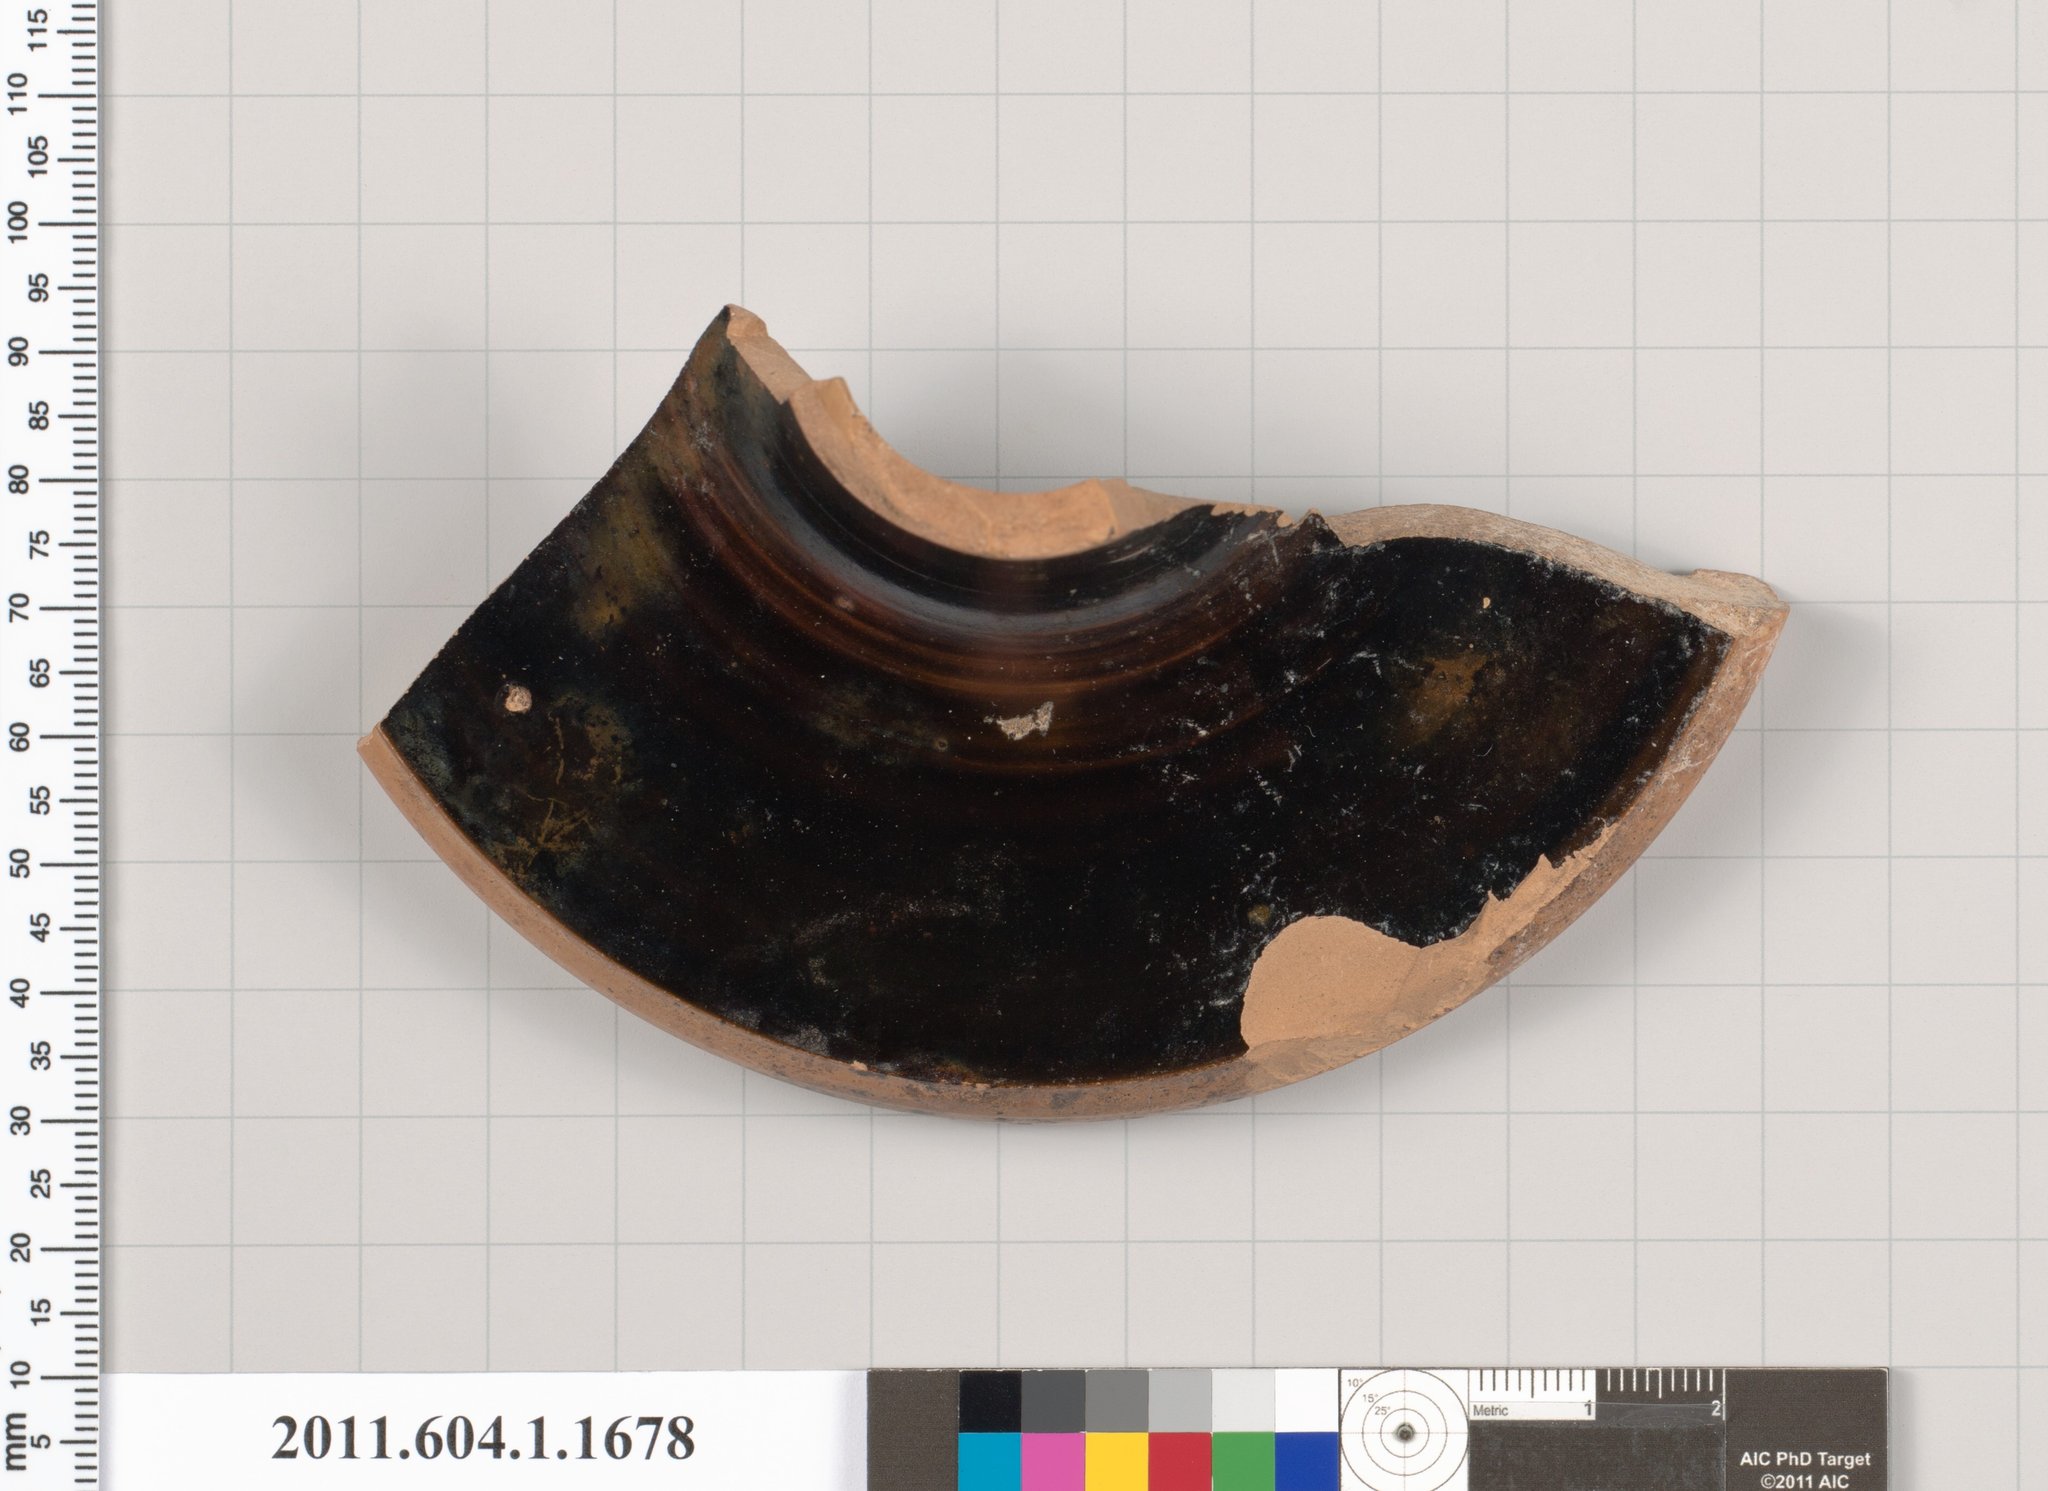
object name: kylix fragment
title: Terracotta fragment of a kylix (drinking cup)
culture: greek, attic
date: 520-500 BCE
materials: terracotta